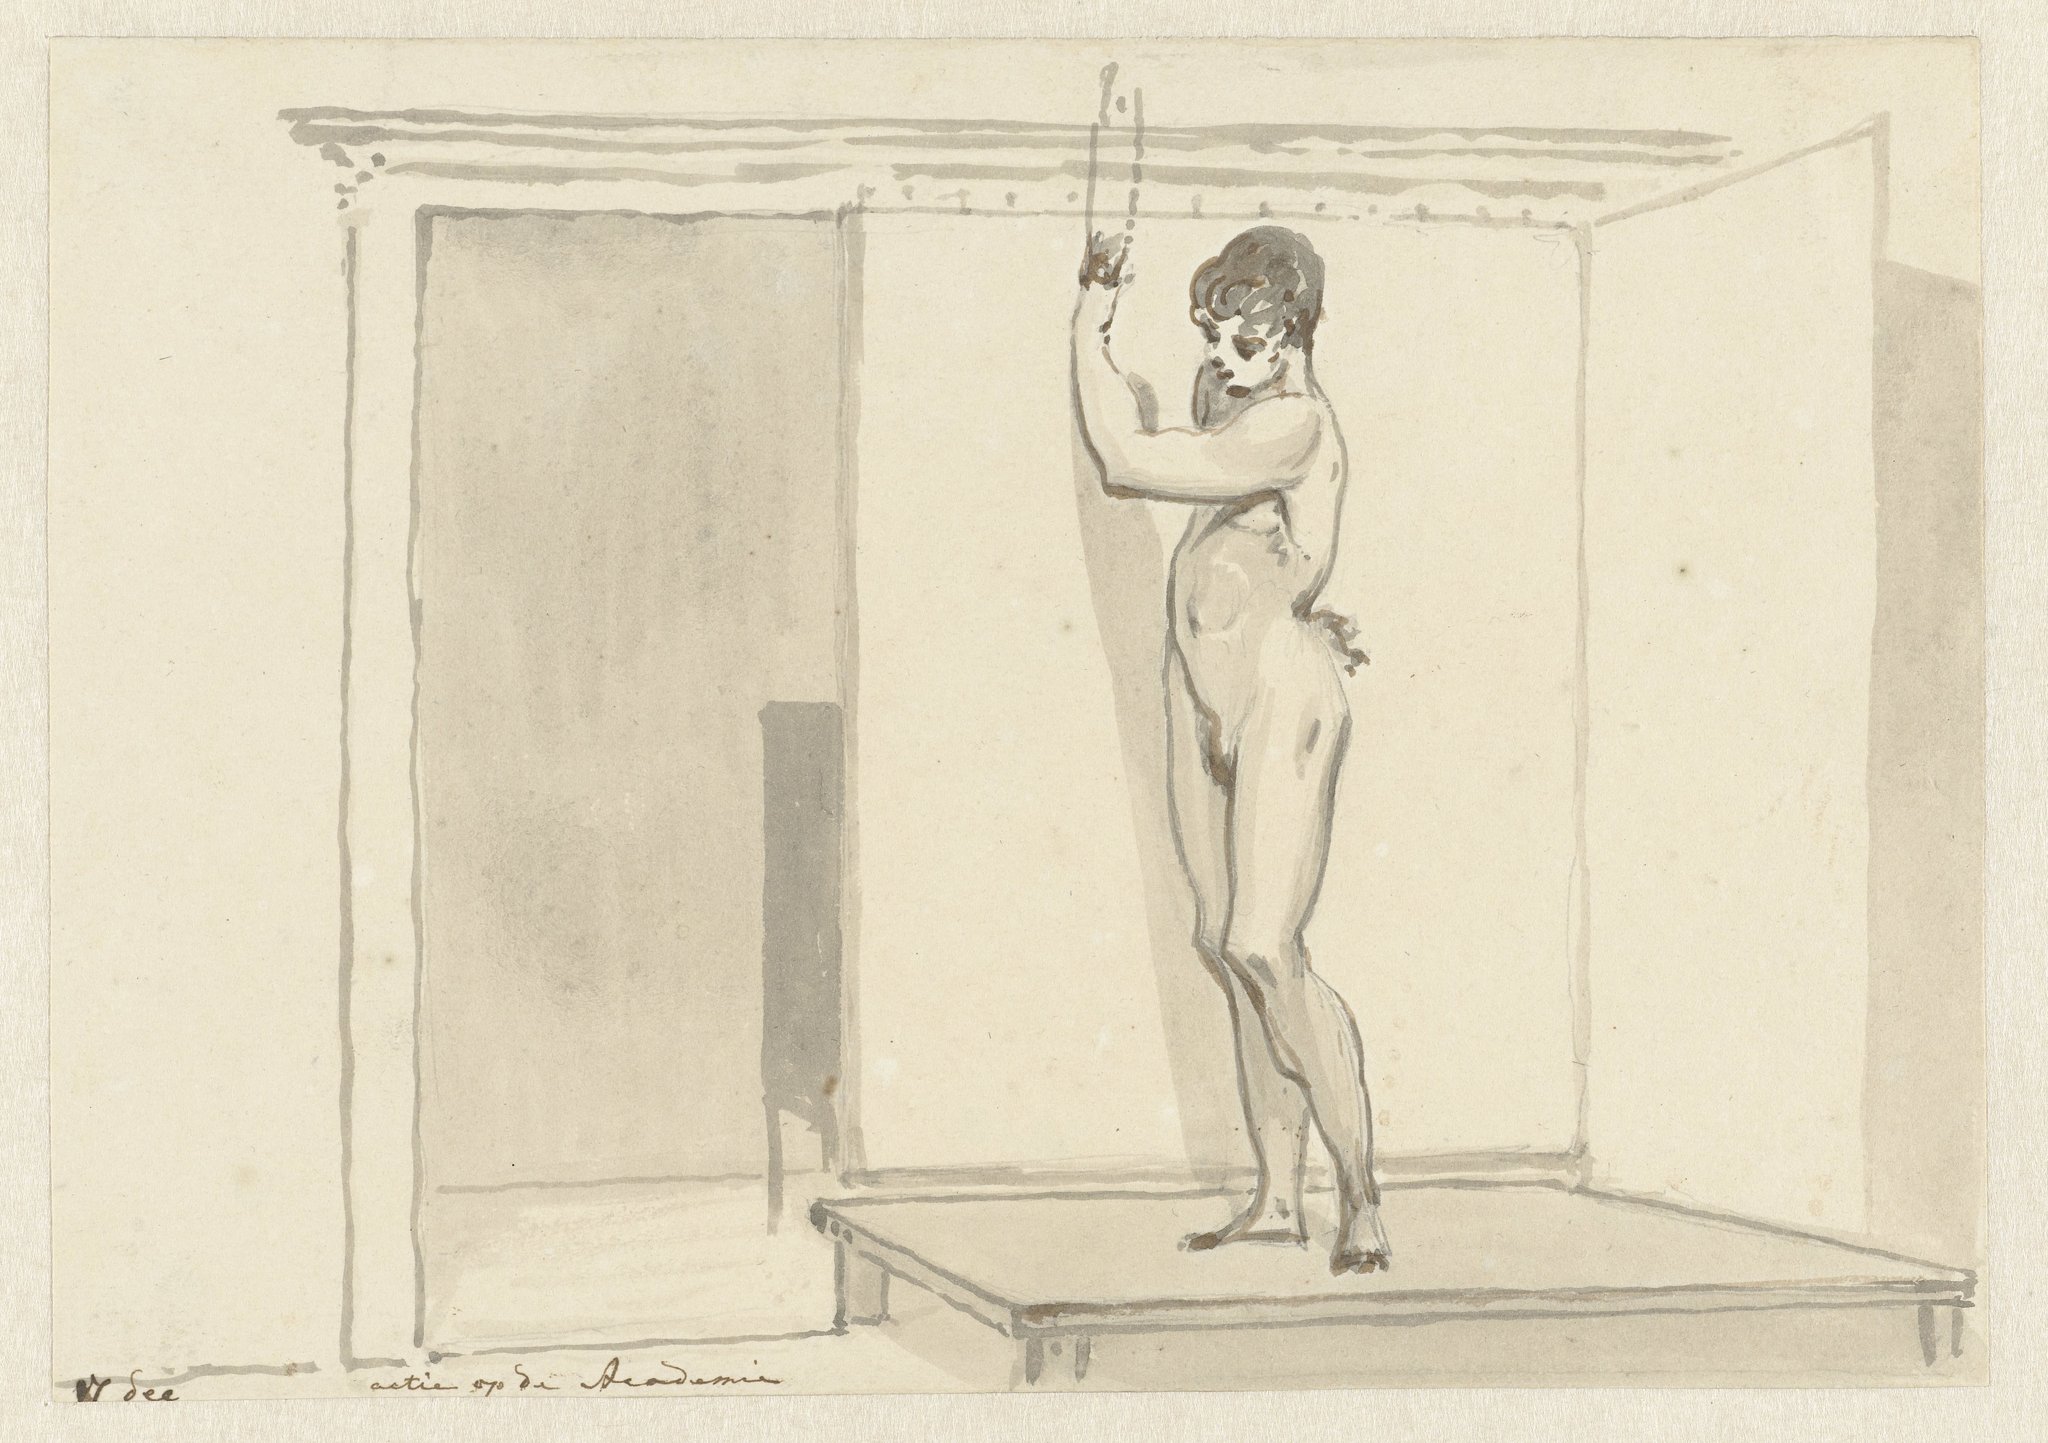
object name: drawing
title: ‘Goings-on at the Academy’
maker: christiaan andriessen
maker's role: draughtsman, print maker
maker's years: 1775-1846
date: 1805-1808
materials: paper, pencil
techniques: brush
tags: artist's model, sitter, standing figure - aa - female human figure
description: While the hair and face suggest otherwise, this model is actually a man. This can be seen from the figure’s muscles and angular contours, as well as the caption. Female nude models were in fact barred at the Amsterdam Drawing Academy. To maintain this pose long enough, the model held onto a string fastened to the ceiling.